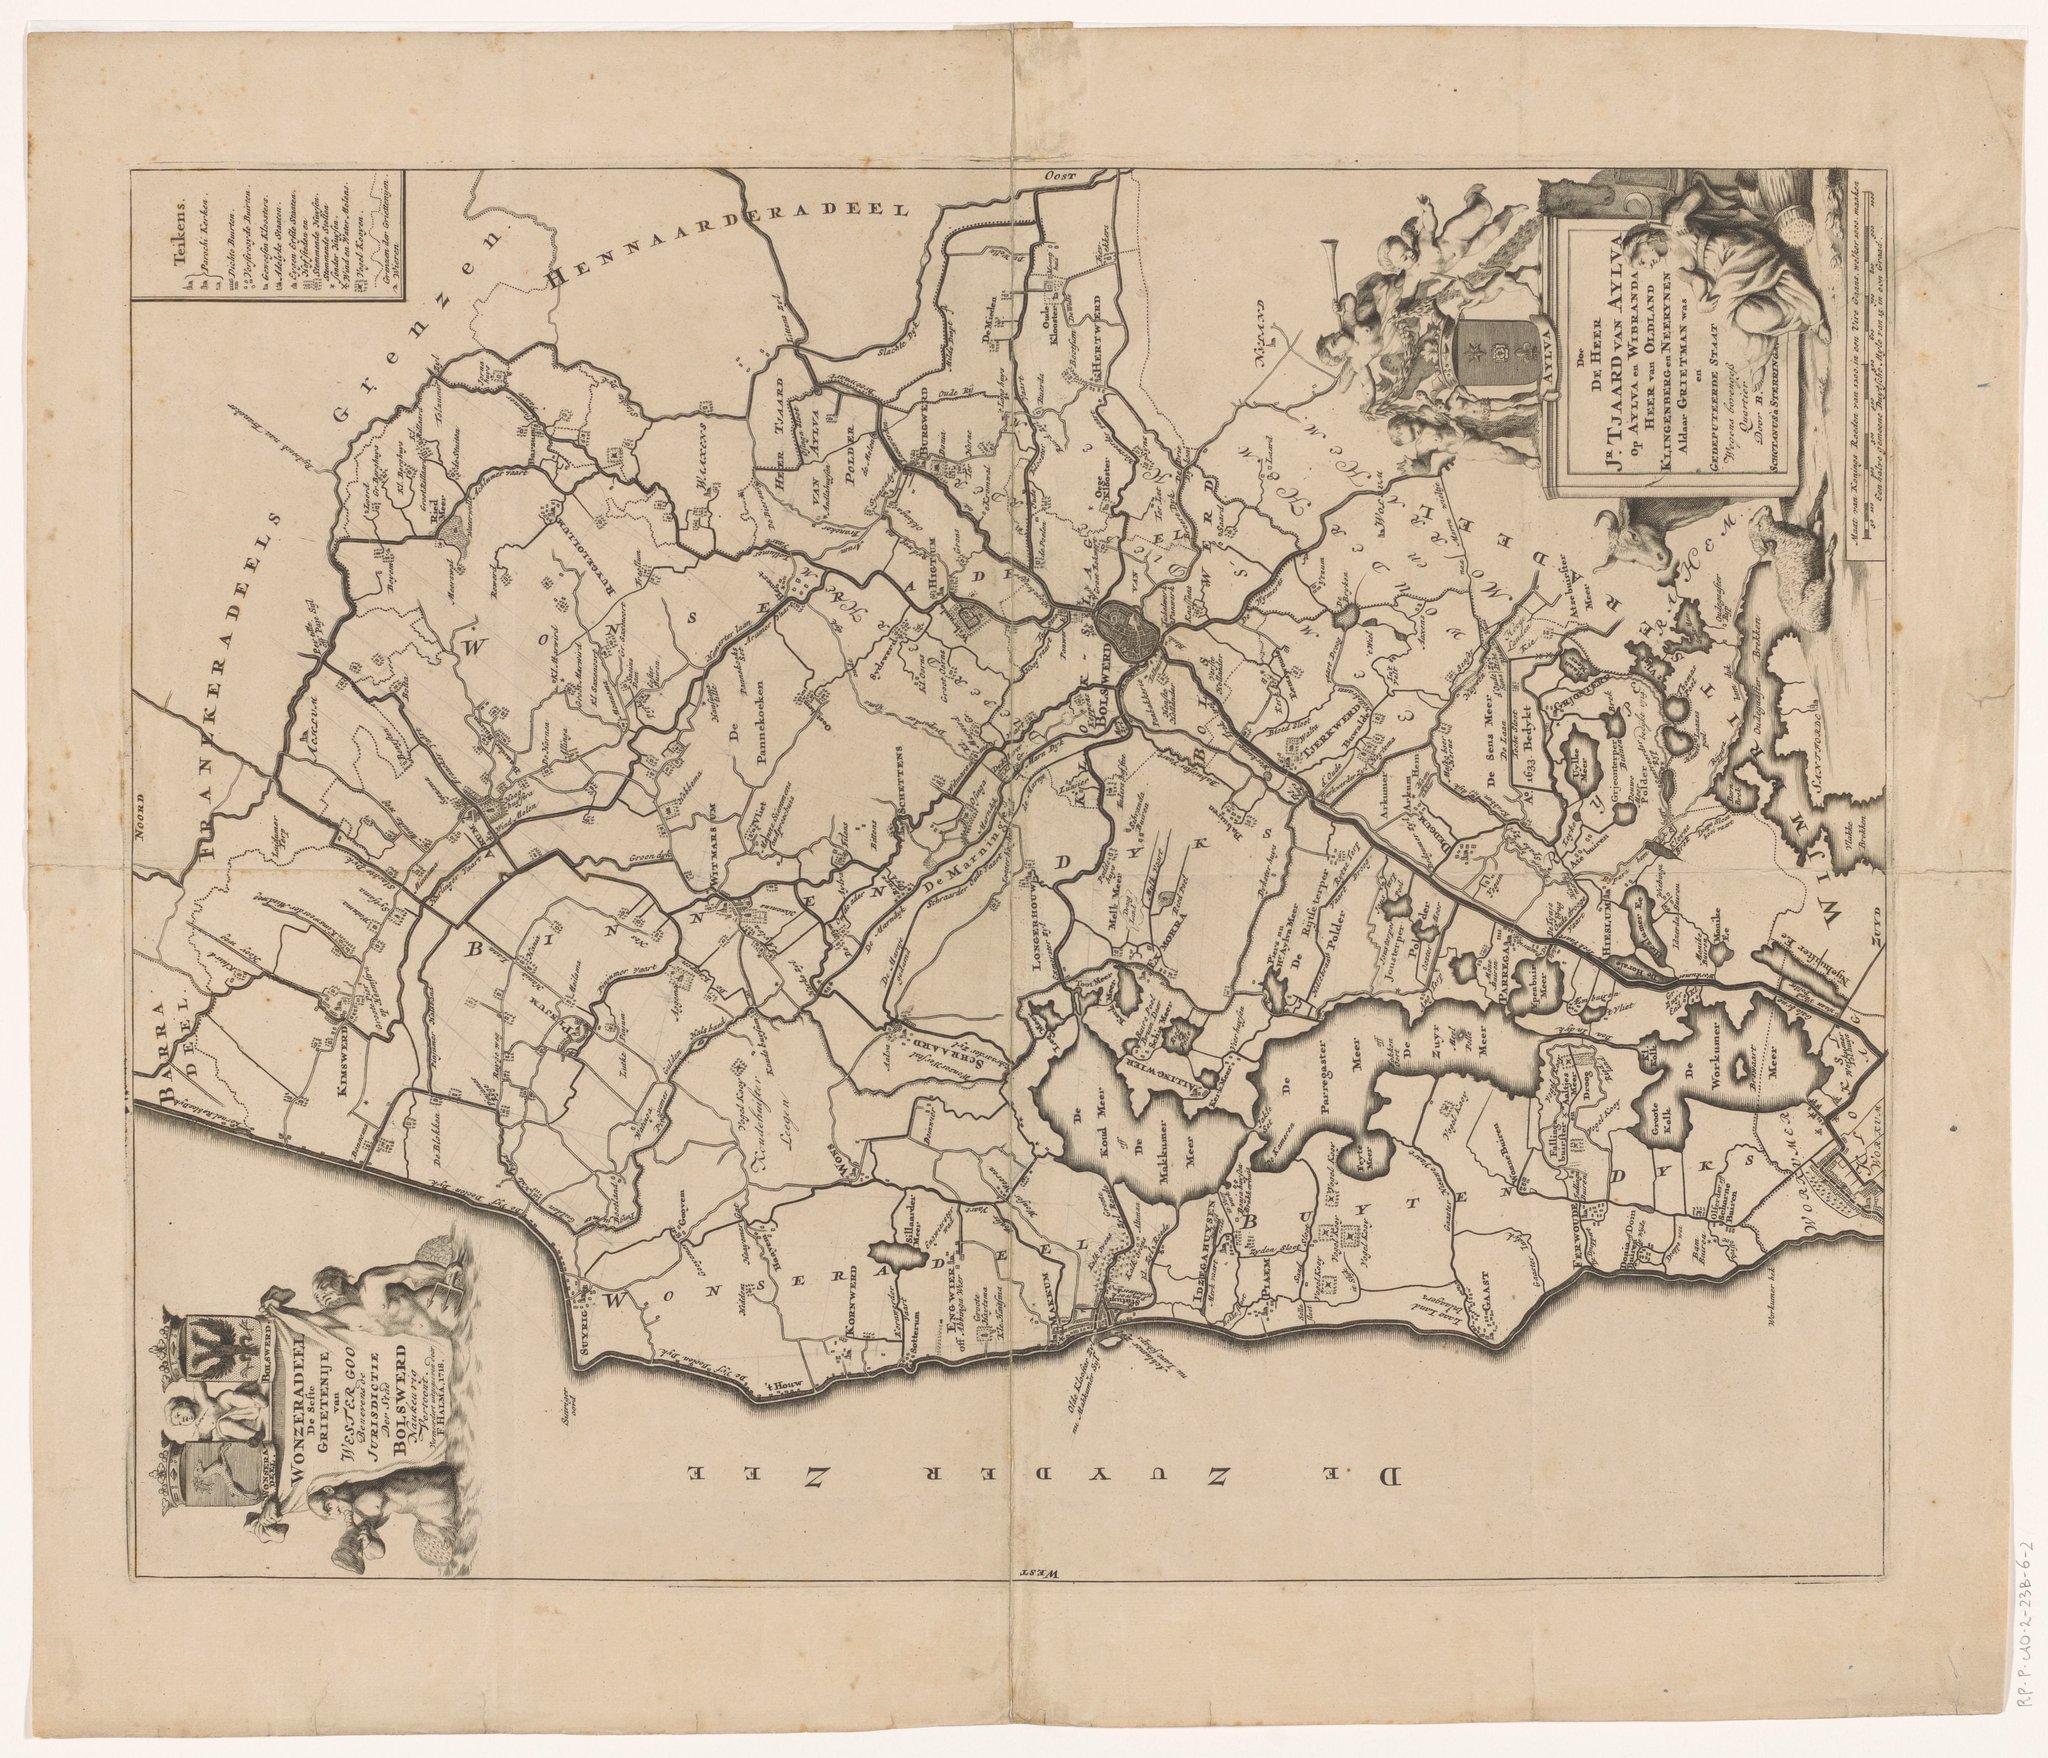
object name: print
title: Wonzeradeel de seste grietenije van Wester goo (...)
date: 1698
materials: paper, pencil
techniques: engraving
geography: leeuwarden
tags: coat of arms (as symbol of the state, etc.), (story of) ceres (demeter), triton(s), maps of separate countries or regions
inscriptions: collector's mark: Lugt 19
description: Linksboven titelcartouche met de wapens van Wonseradeel en Bolsward, daaromheen twee tritons. Rechtsboven legenda, rechtsonder cartouche met bestuurlijke informatie over de grietenij, daaromheen het wapen van grietman jonker Tjaard van Aylva, drie putti, vee en Ceres. Daaronder een schaalstok: Maat van konings roeden van 1200 in een uire gaans, welker 1000 maaken een halve gemeene Duytsche myle van 15 in een graad. Met rooster.